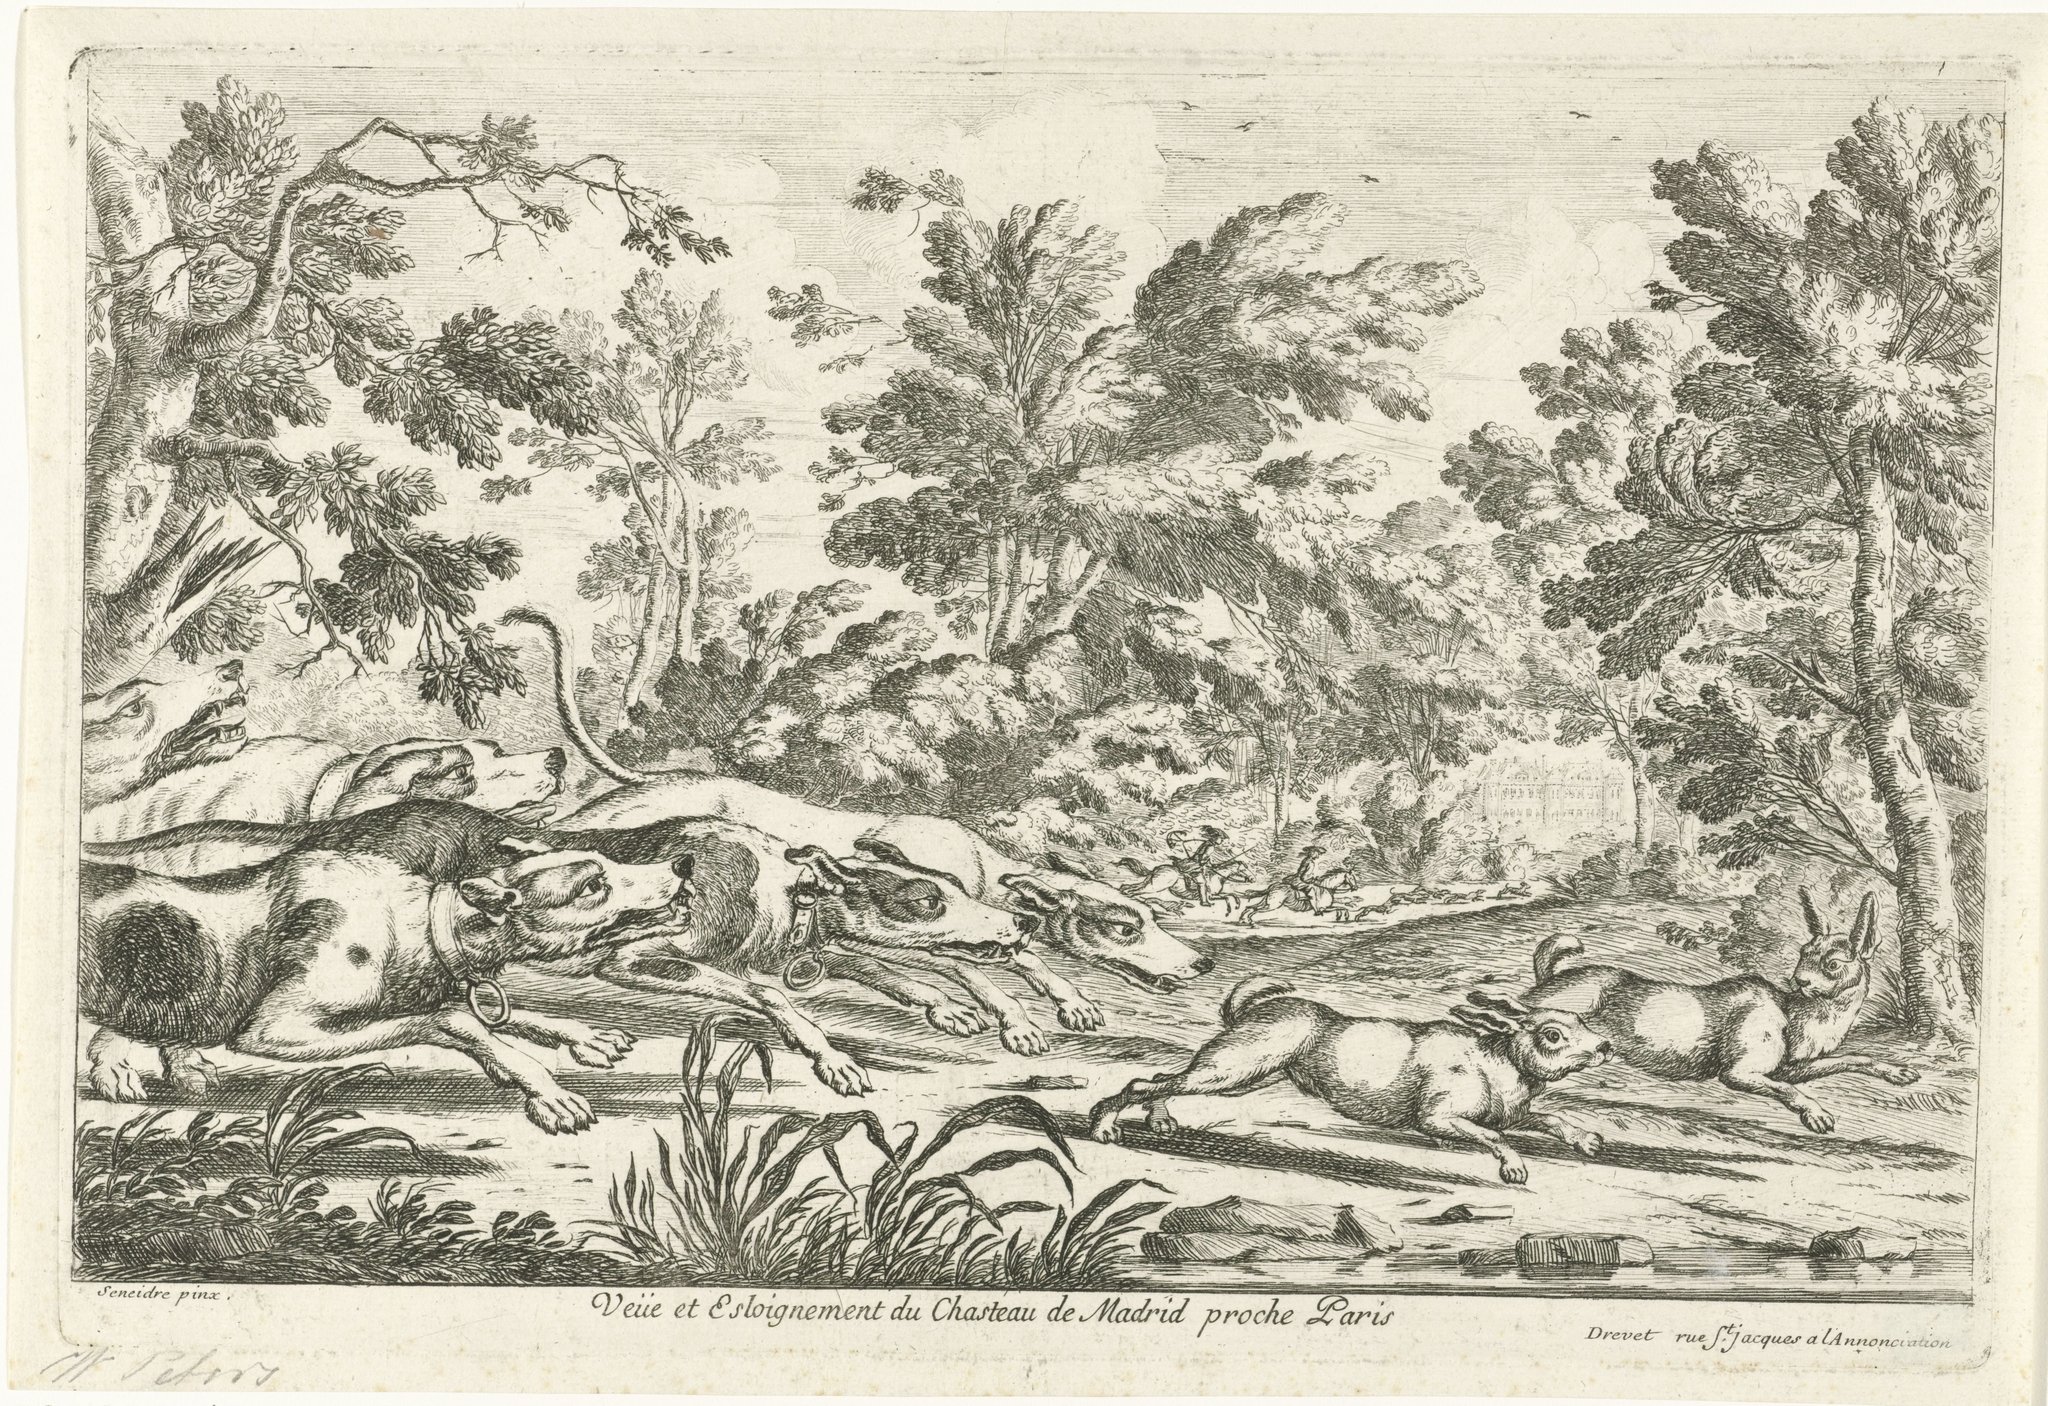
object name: print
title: Jachten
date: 1622-1653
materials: paper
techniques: etching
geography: antwerp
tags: hare-hunting, rabbit-hunting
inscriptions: collector's mark: Lugt 2165, collector's mark: Lugt 2228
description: Landschap met een hazenjacht. Rechts op de achtergrond een gezicht op Château de Madrid, nabij Parijs. In de marge een onderschrift in het Frans.